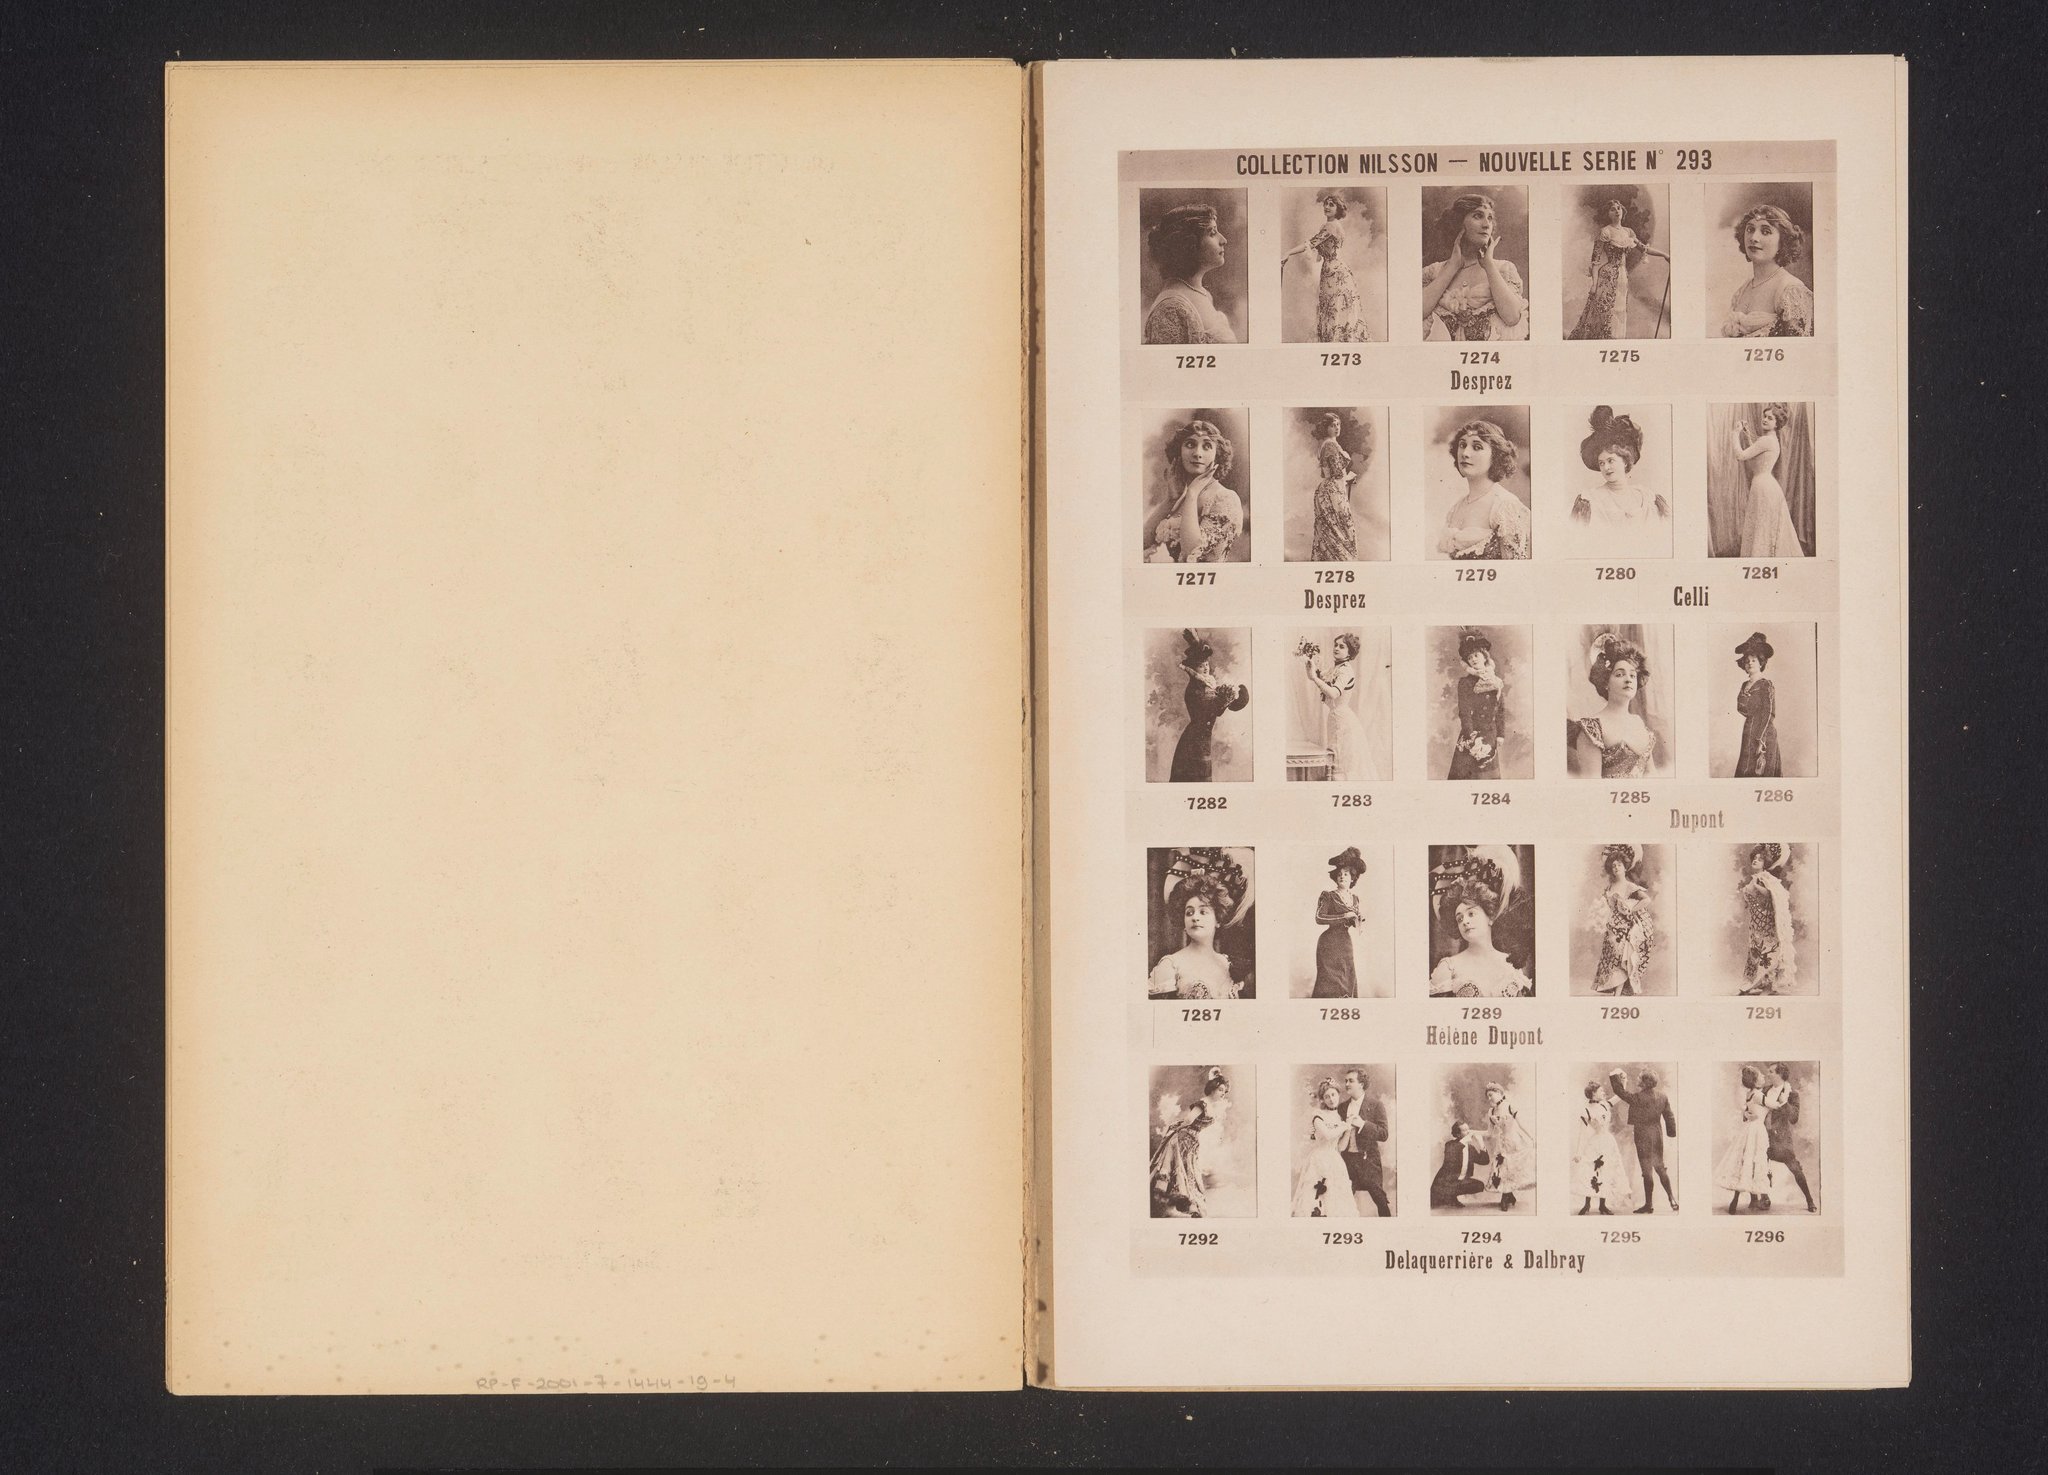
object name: photomechanical print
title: Collection Nilsson - Nouvelle Série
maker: Anonymous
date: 1895-1900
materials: paper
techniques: photograph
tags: historical persons - bb - woman, historical persons, portrait of opera-singer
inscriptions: number: ‘No 293’